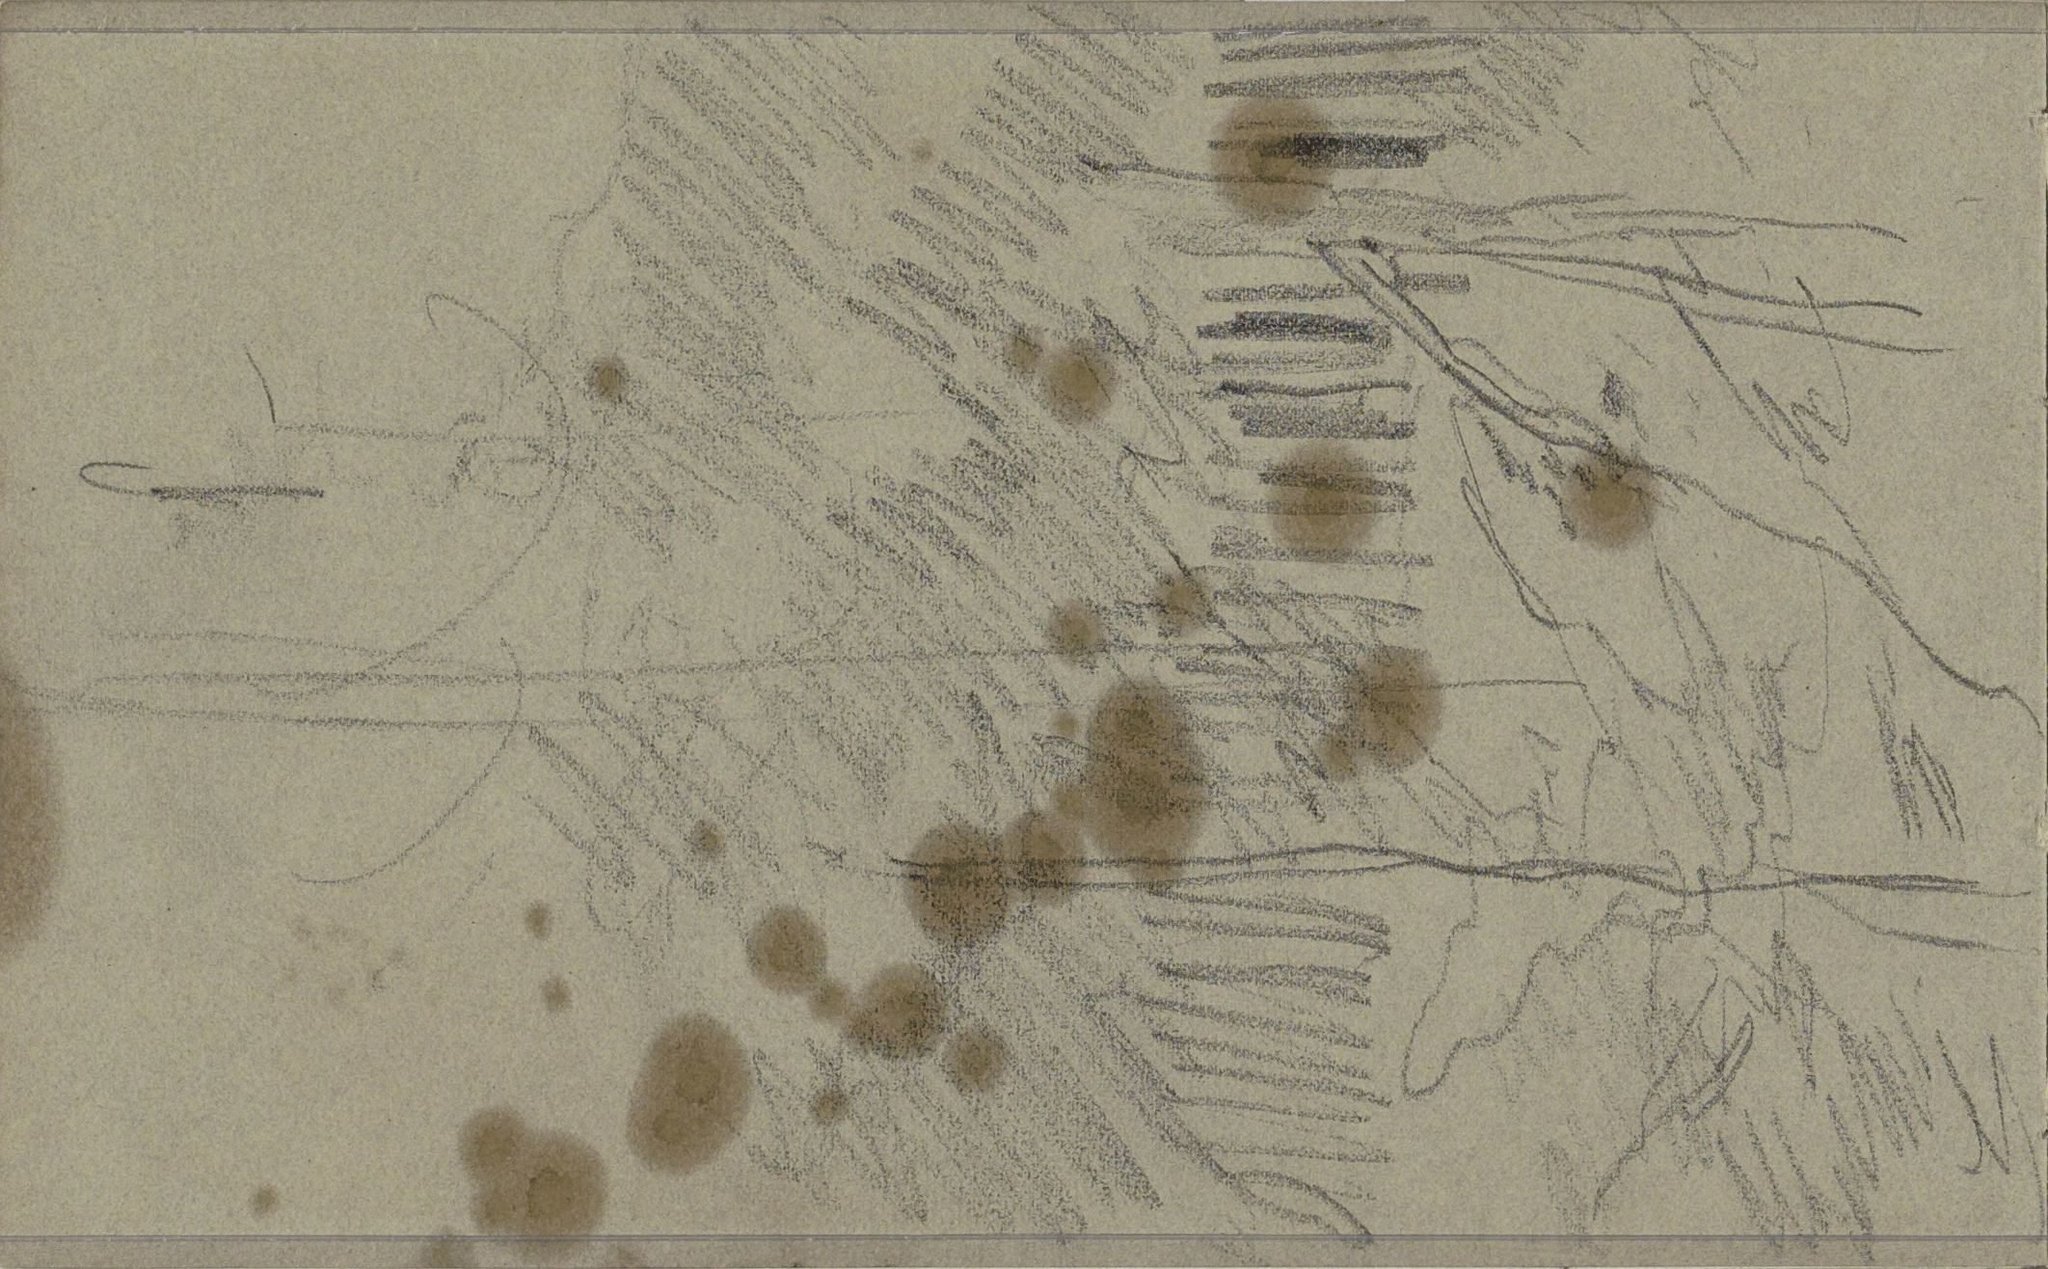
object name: sketchbook leaf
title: Weide met een hek en bomen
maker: anton mauve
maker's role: draughtsman, painter, print maker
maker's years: 1838-1888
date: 1848-1888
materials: paper, pencil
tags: fence, wall, paling, meadow, pasture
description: Blad 35 verso uit een schetsboek met 43 bladen.